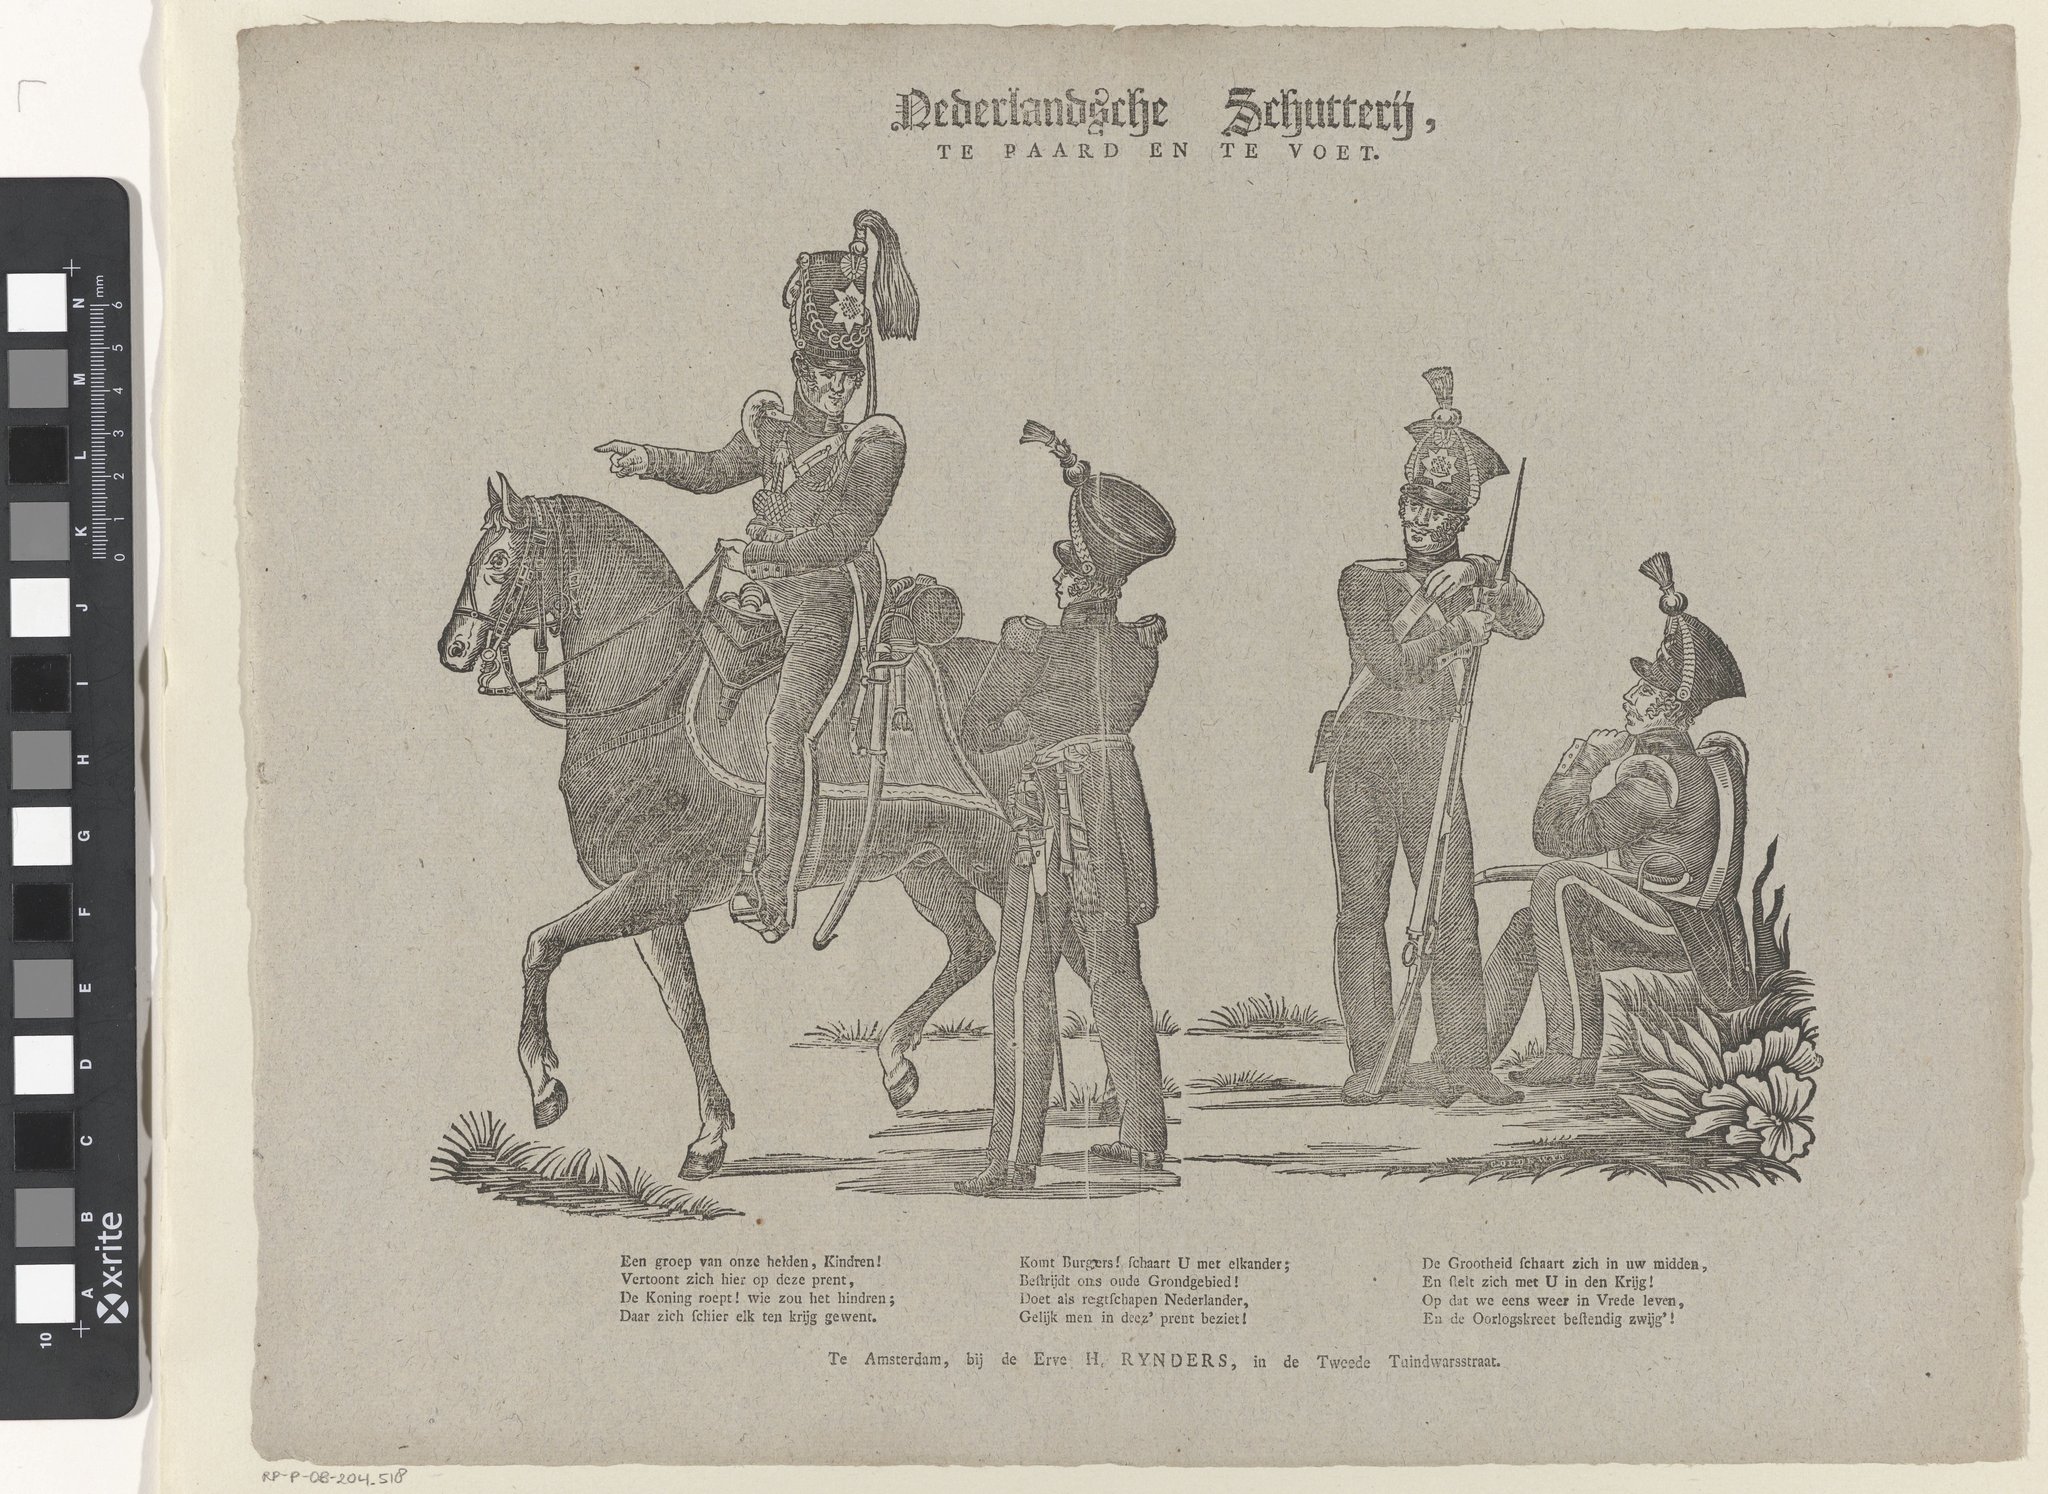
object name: print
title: Nederlandsche schutterij, / te paard en te voet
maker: Anonymous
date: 1831-1854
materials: paper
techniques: letterpress printing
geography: netherlands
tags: artillery range, firing range, shooting range ~ military training, warfare; military affairs (+ cavalry, horsemen), the soldier; the soldier's life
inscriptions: collector's mark: Lugt 2760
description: Blad met een grote voorstelling van vier militairen, waarvan één te paard. Onder de afbeelding een twaalfregelig vers in drie kolommen.